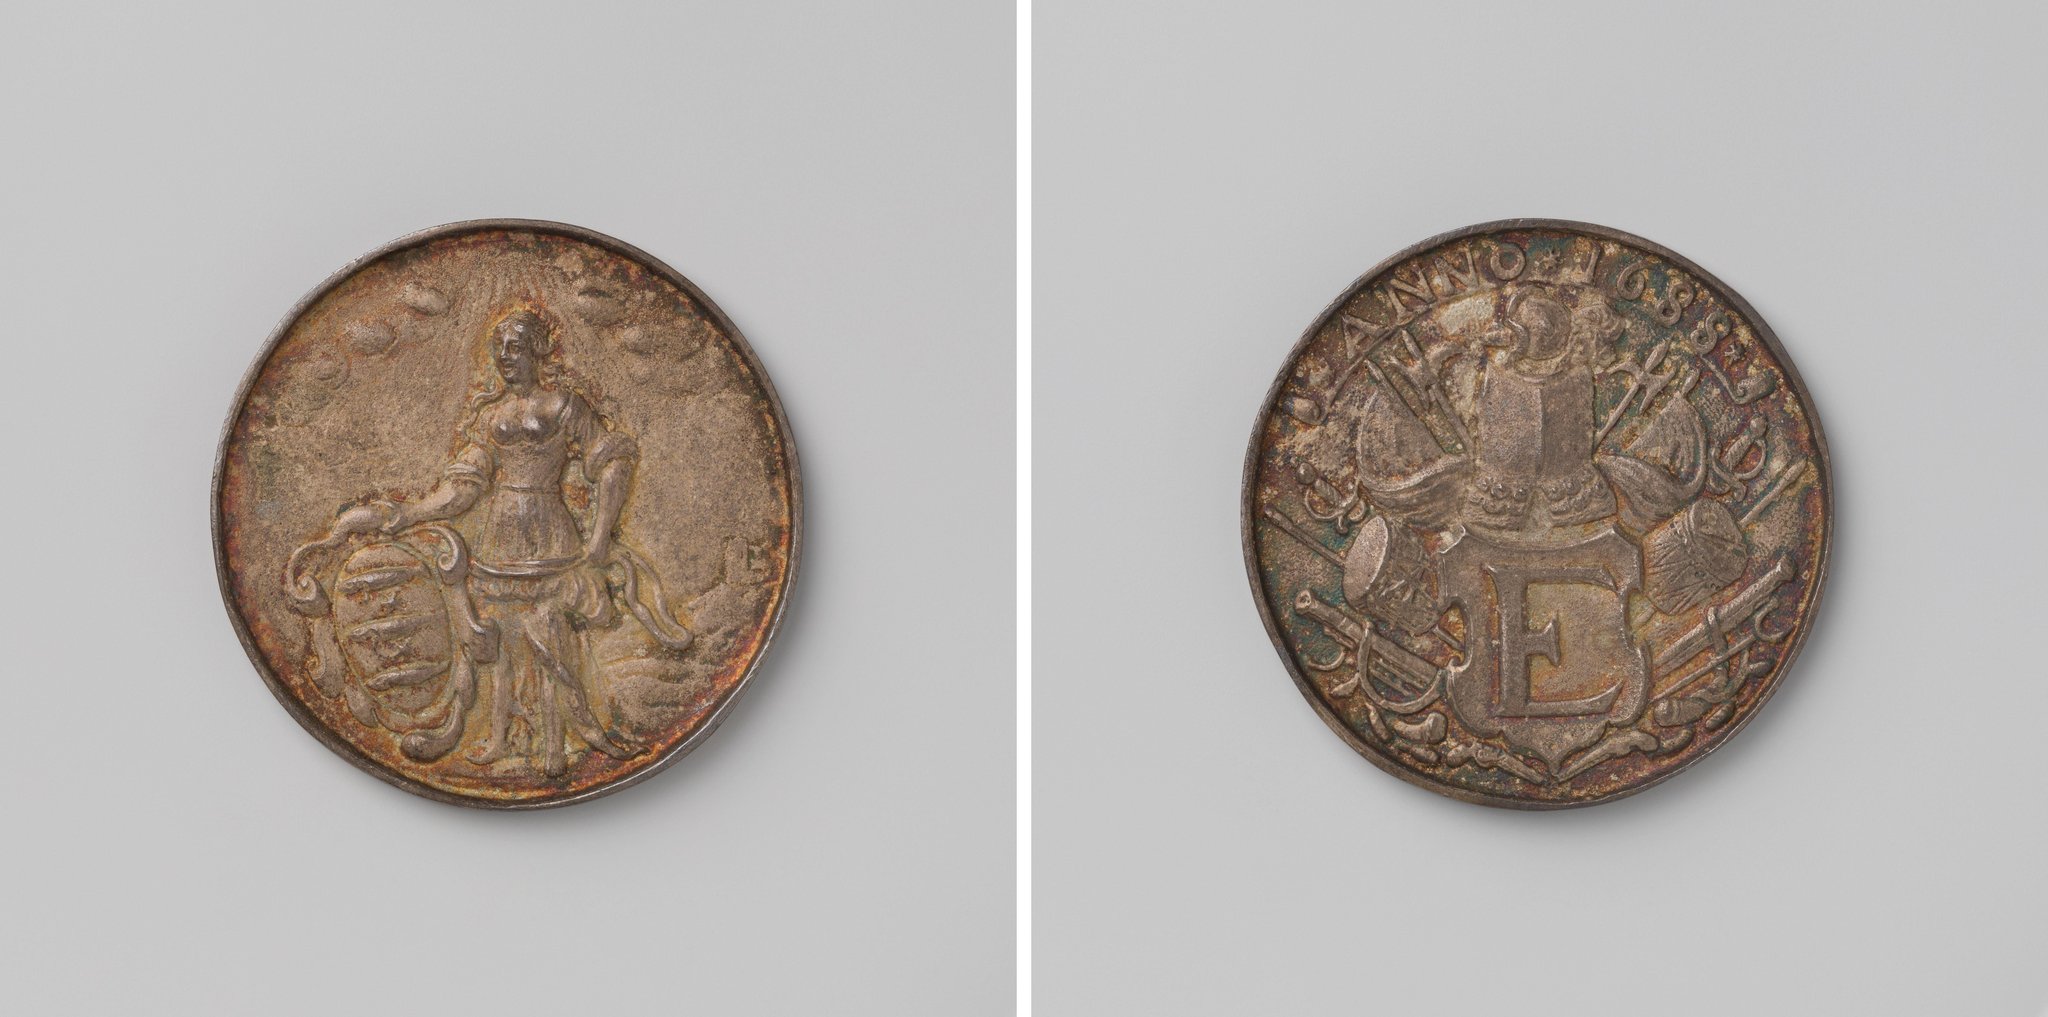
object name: marksman medal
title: Schutterij van Enkhuizen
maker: Anonymous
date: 1688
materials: silver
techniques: casting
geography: enkhuizen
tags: enkhuizen